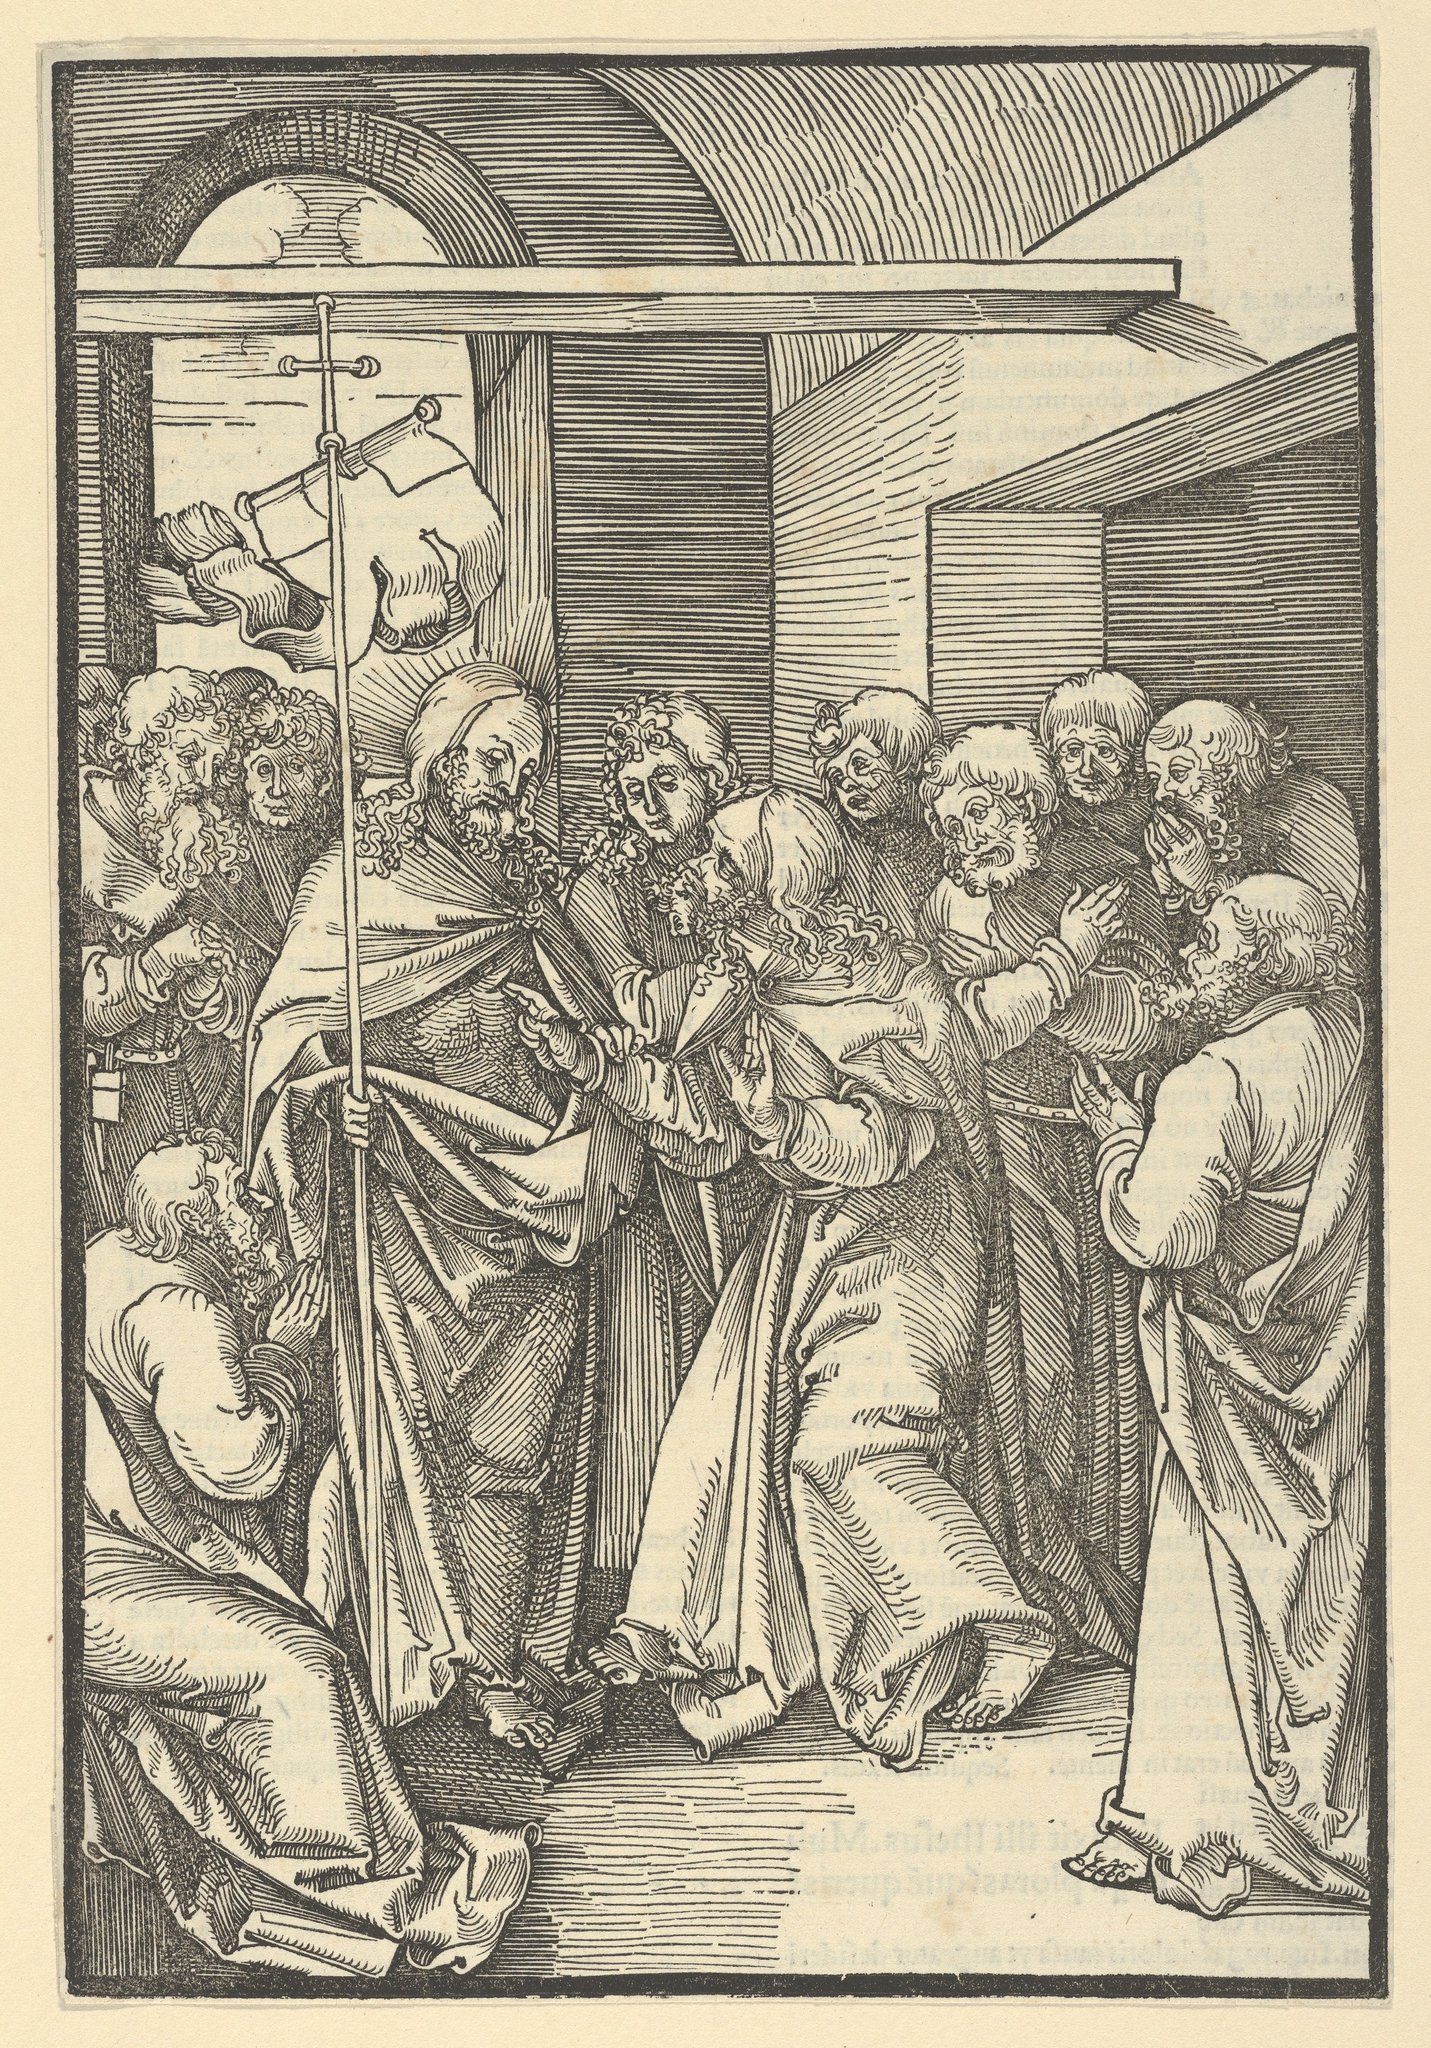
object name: print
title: The Incredulity of Thomas, from Speculum passionis domini nostri Ihesu Christi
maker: hans schäufelein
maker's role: artist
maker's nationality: german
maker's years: 1480-1540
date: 1507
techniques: woodcut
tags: suffering,jesus,saints